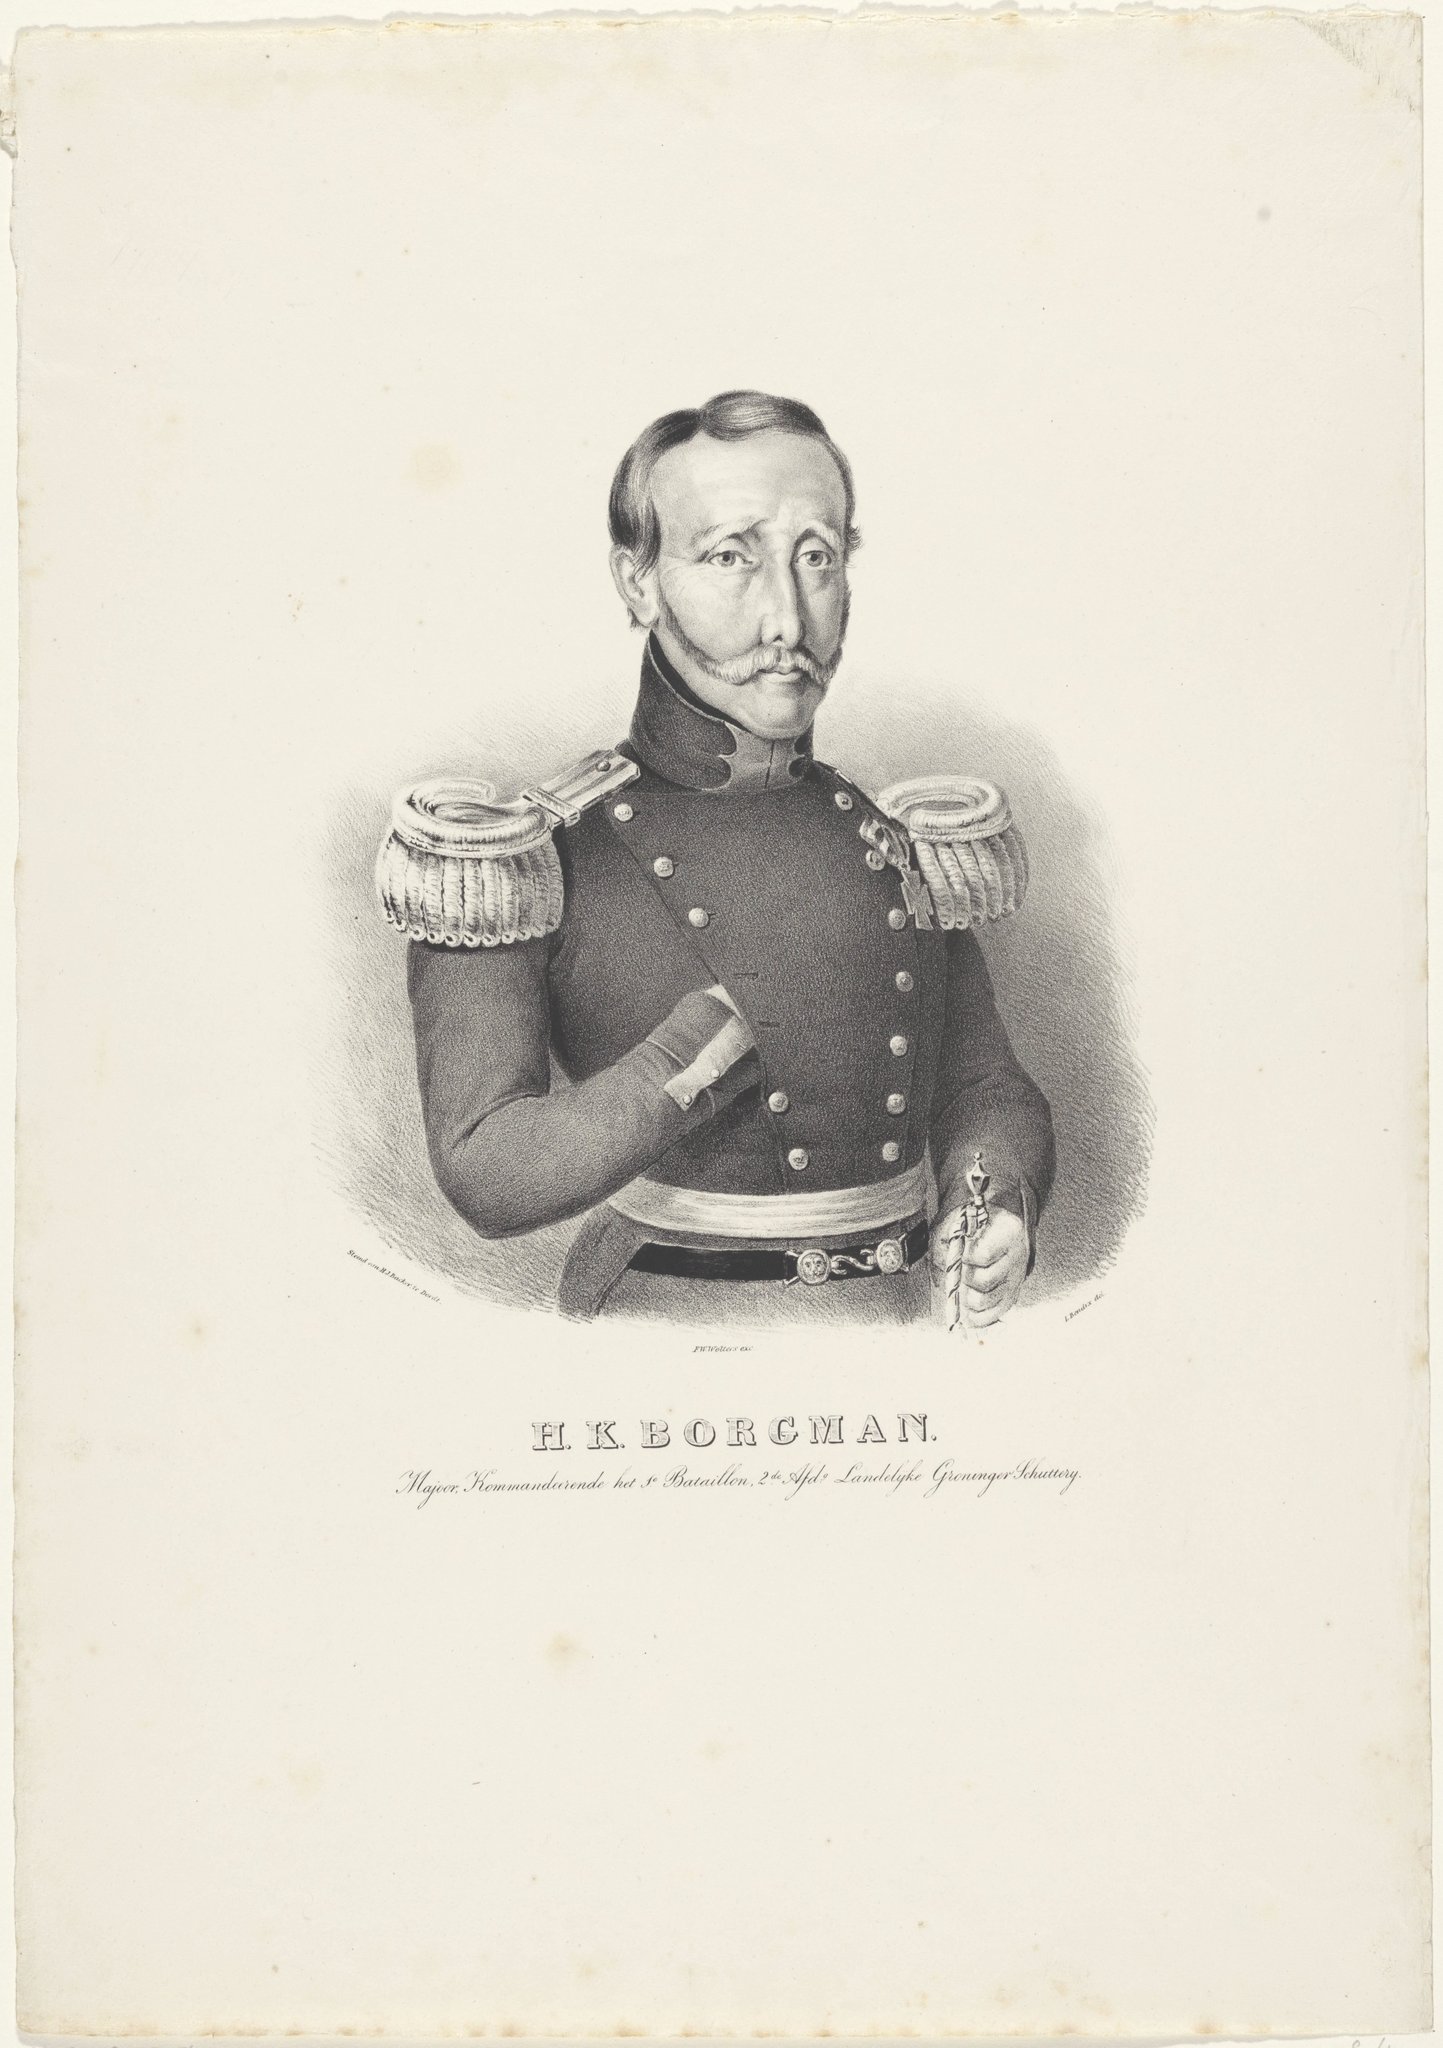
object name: print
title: Portret van majoor Hindrik Klasen Borgman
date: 1835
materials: paper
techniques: lithograph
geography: leeuwarden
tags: historical persons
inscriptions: collector's mark: Lugt 2228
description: De geportretteerde heeft zijn rechterhand in zijn jas gestoken. Hij draagt een uniform en in zijn linkerhand een sabel. Op zijn borst draagt hij een ridderorde.